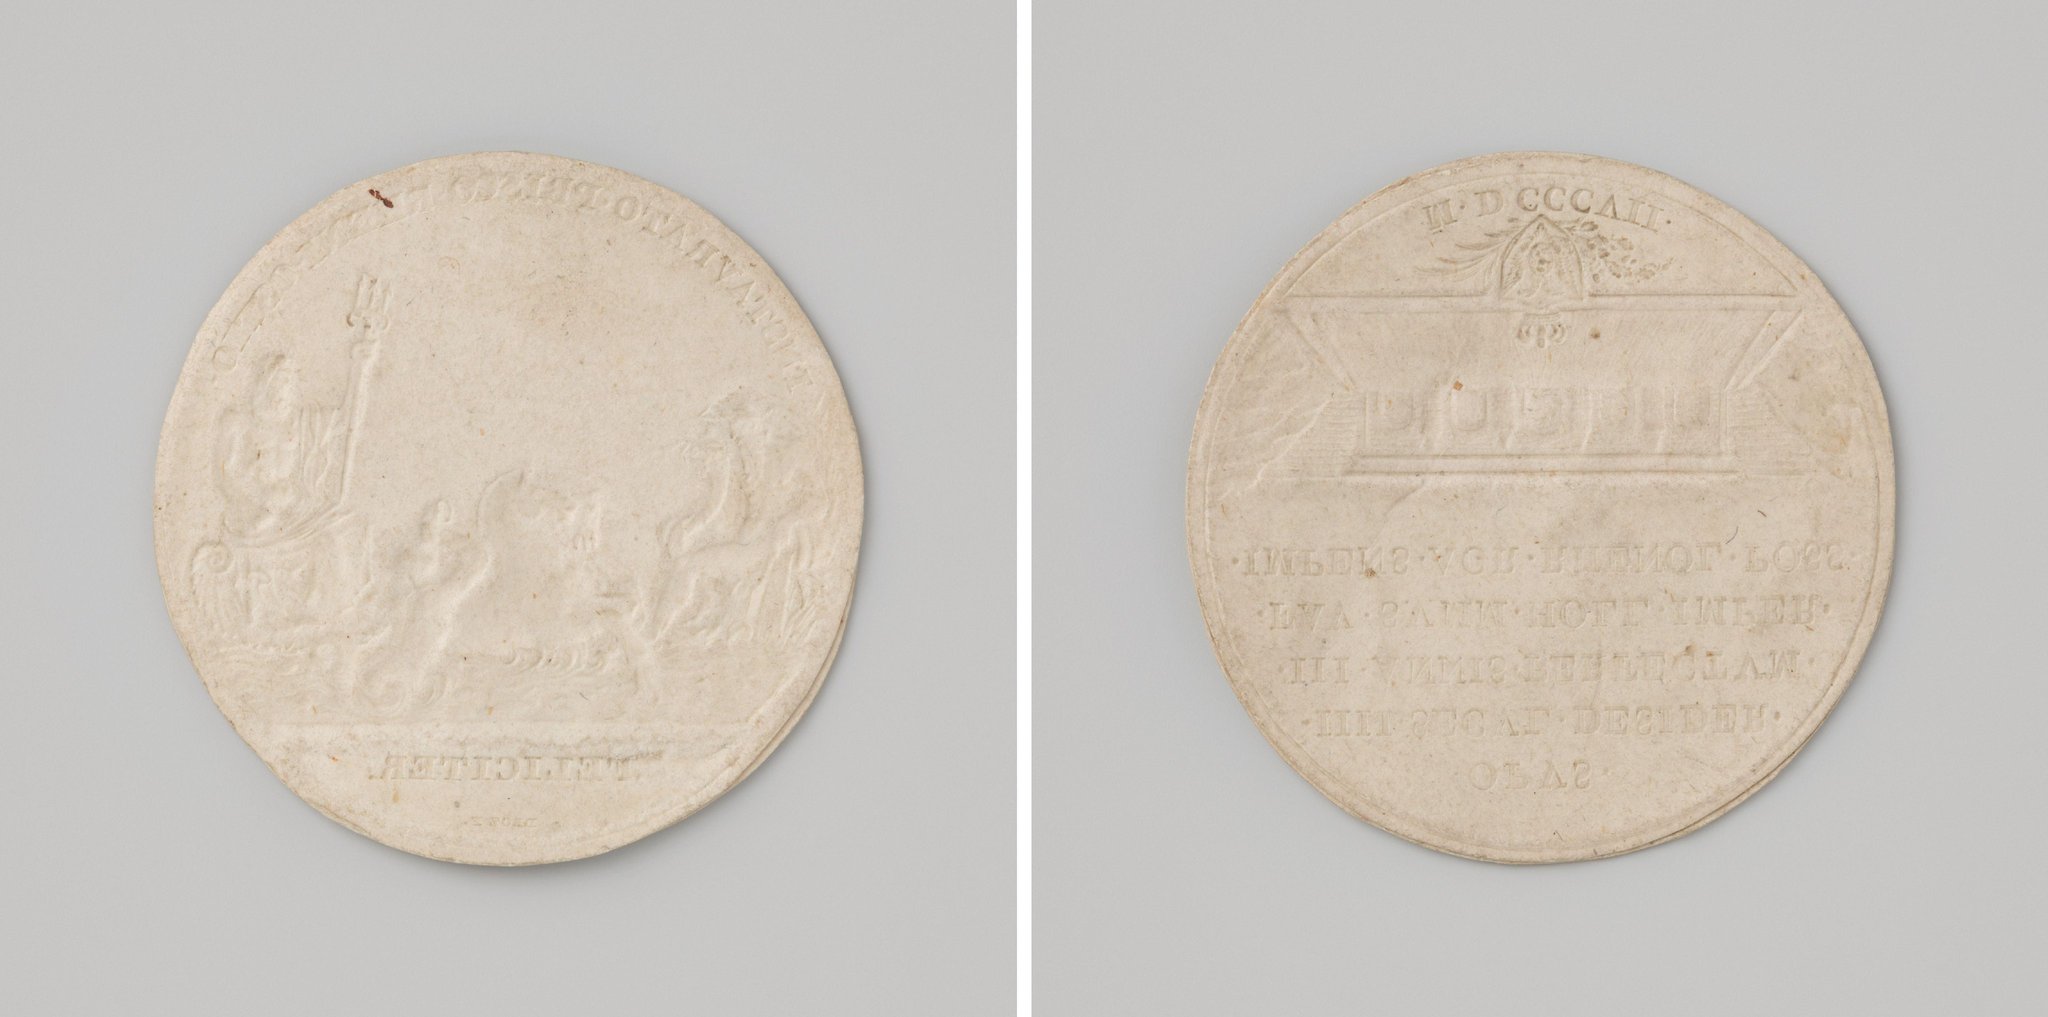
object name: history medal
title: Voltooiing van de sluizen te Katwijk 1807, afdruk in karton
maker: jean-pierre droz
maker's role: medailleur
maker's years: 1746-1823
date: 1807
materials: cardboard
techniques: pressing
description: Aaneengelijmde incuse afdrukken in karton van voor- en keerzijde van de penning, op de voorzijde Neptunus in een schelp getrokken door hippocampen waarnaast een hoornblazende meerman, op de oever een zittende riviergod,, met omschrift en afsnedetekst, op de keerzijde het aanzicht van de sluizen met daar boven vijf regels tekst en onder een klein gekroond wapenschild van Rijnland tussen takken en het jaartal.